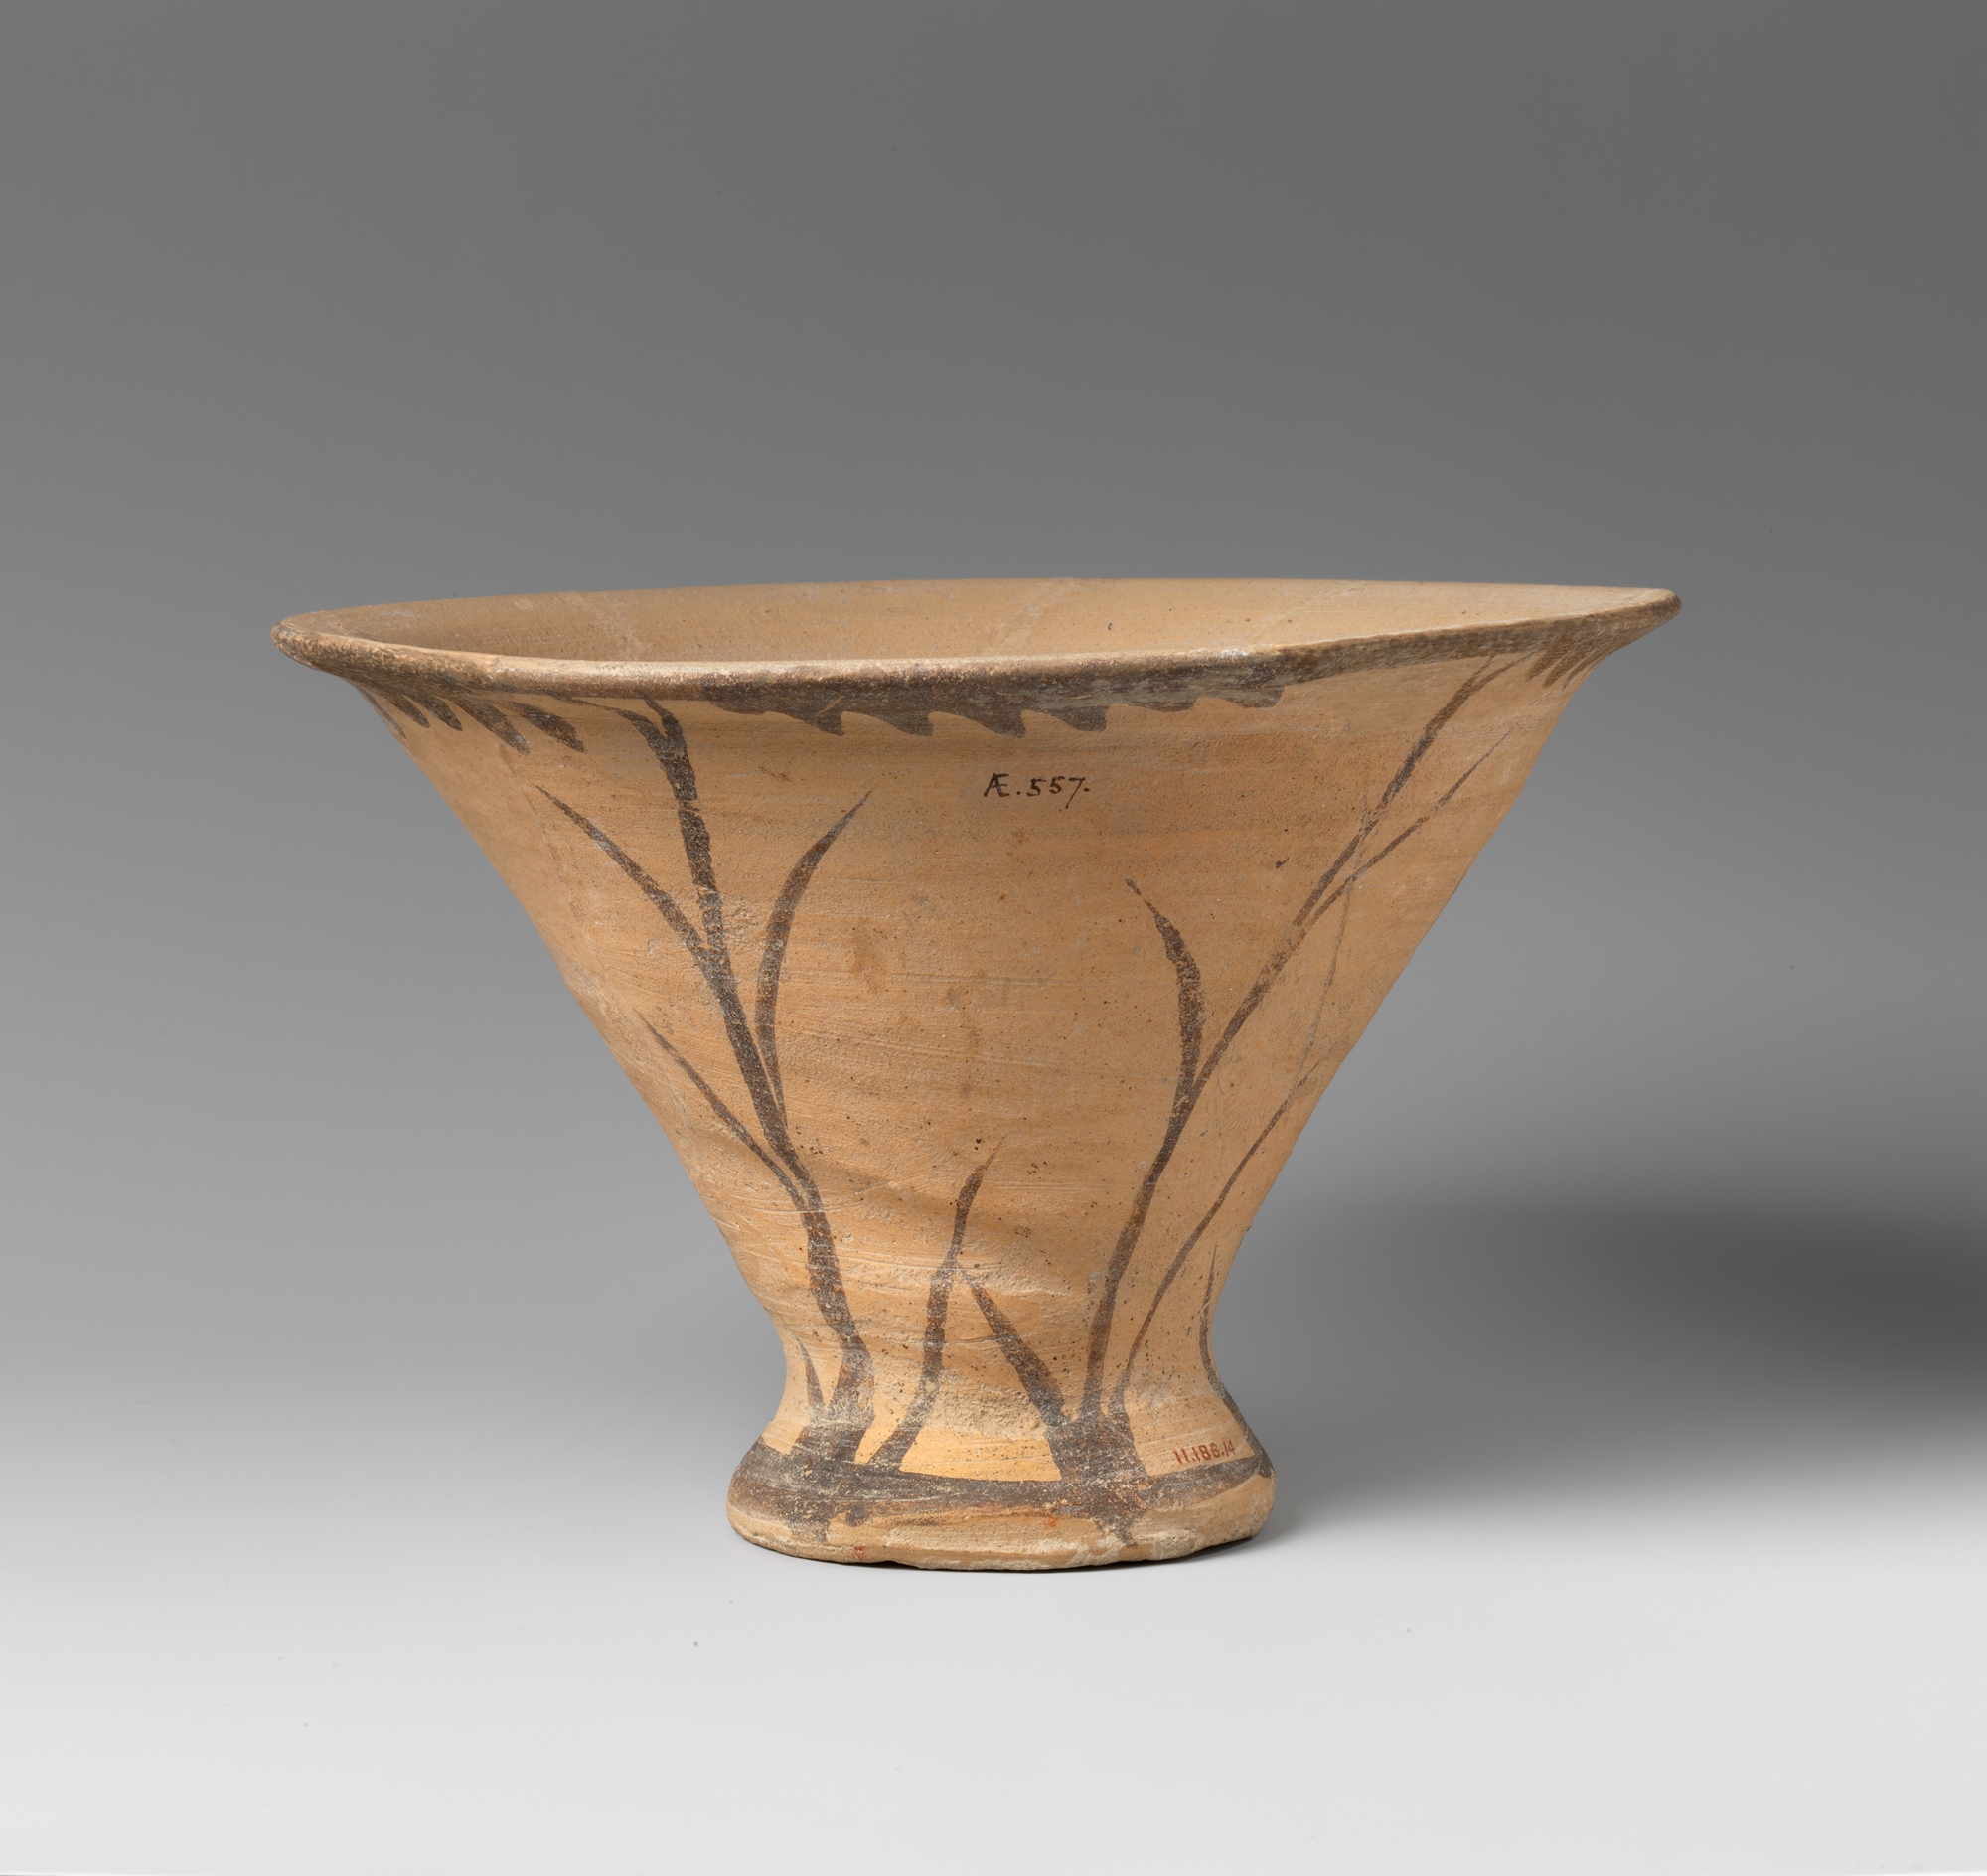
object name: kalathos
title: Terracotta kalathos (vase with flaring lip)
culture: cycladic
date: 1550-1425 BCE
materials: terracotta